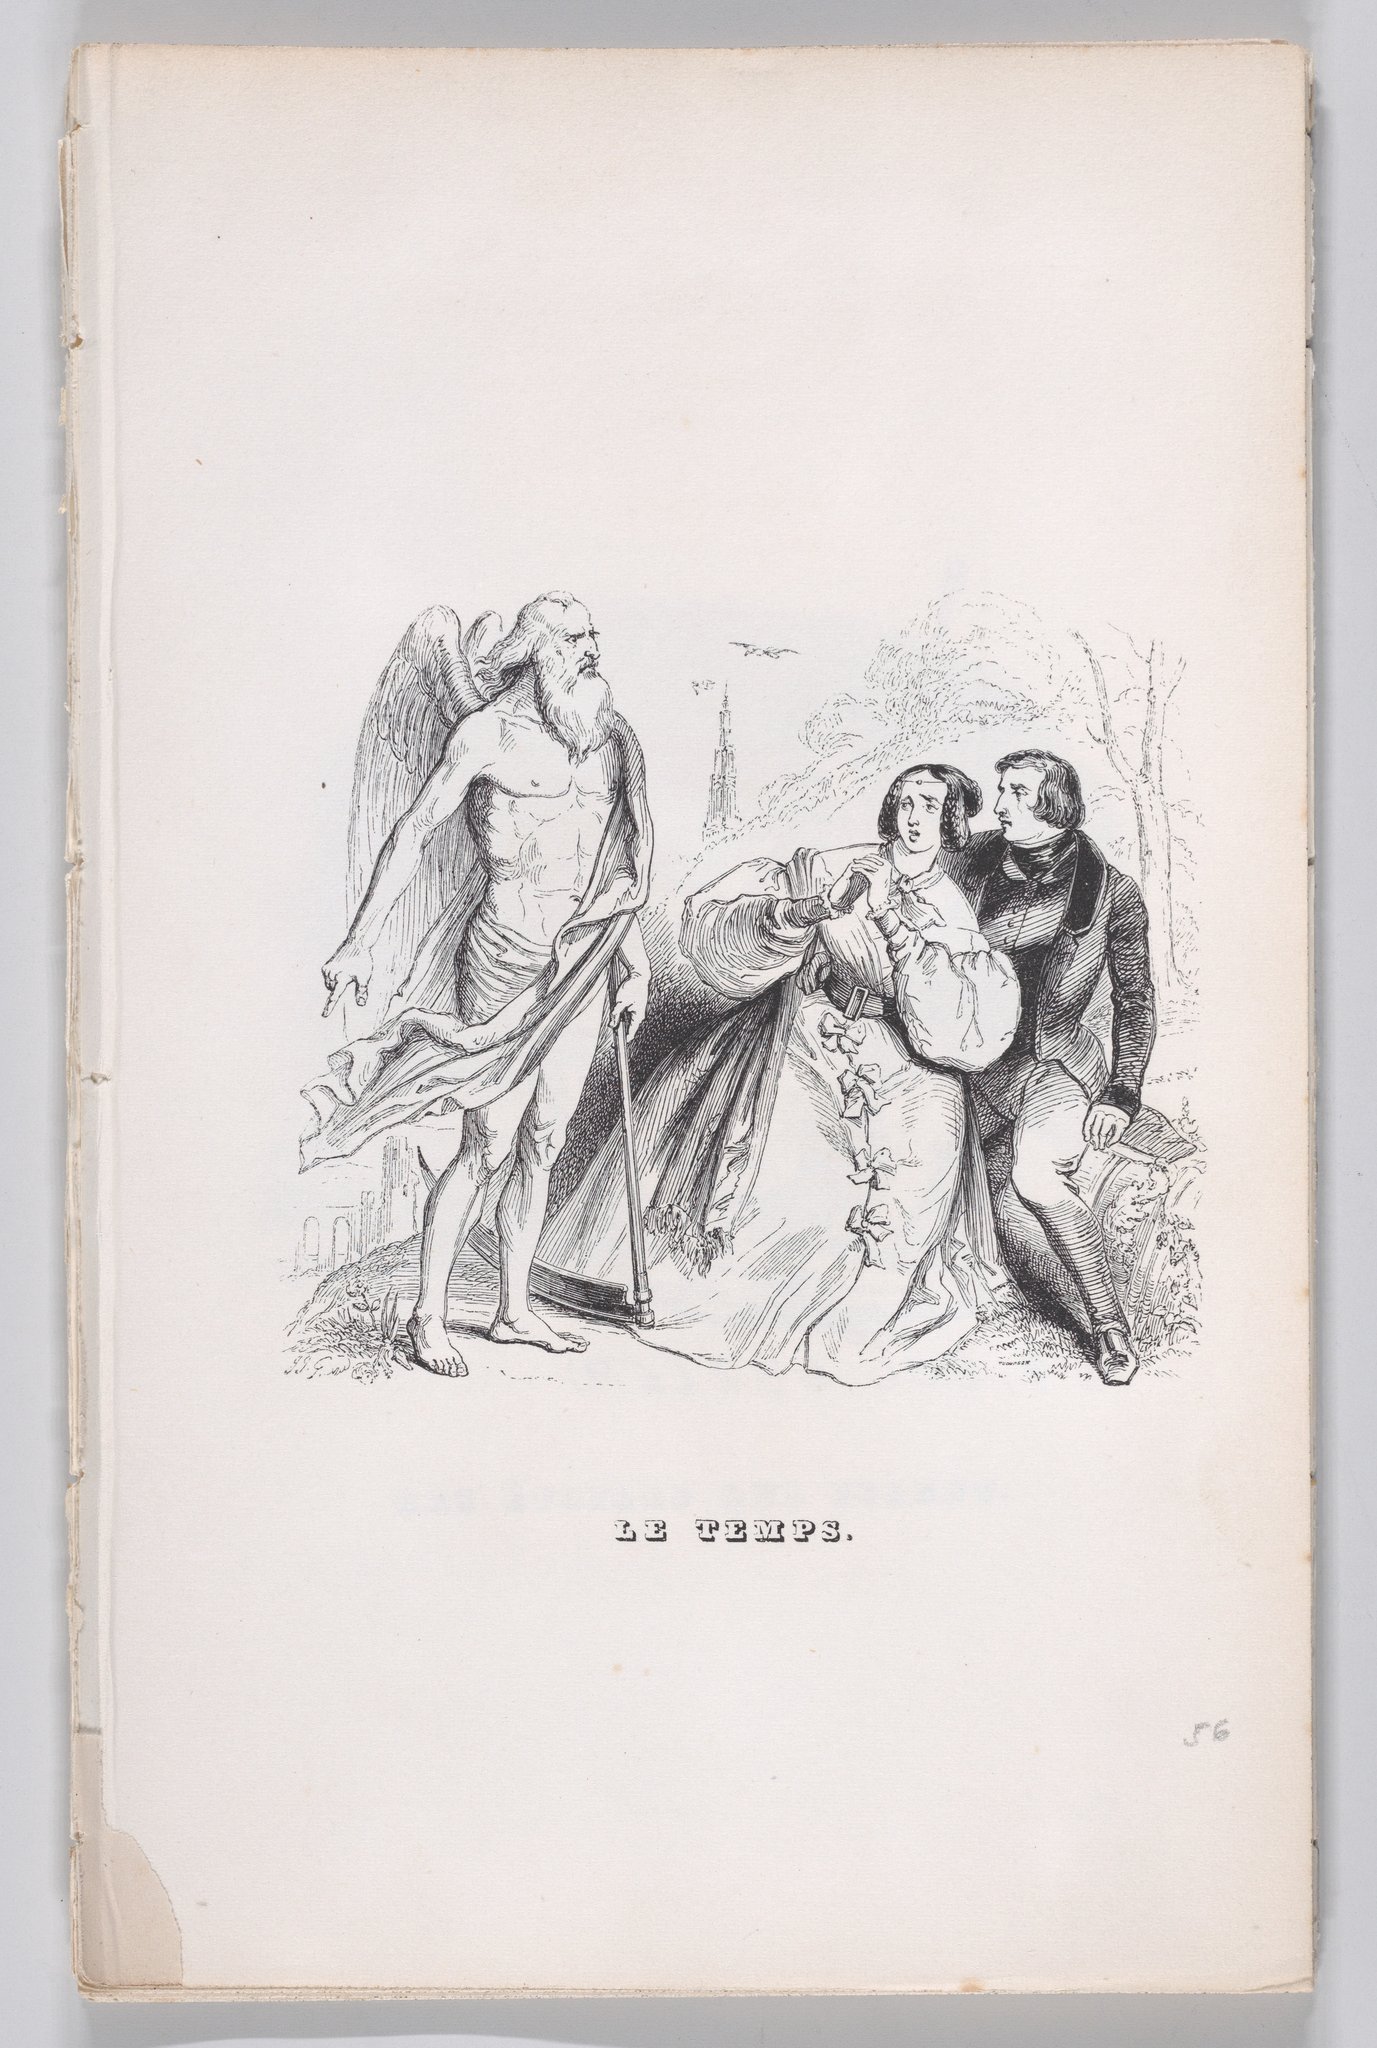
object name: print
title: Time, from "The Complete Works of Béranger"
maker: j. j. grandville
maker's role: illustrator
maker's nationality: french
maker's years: 1803-1847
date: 1836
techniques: engraving